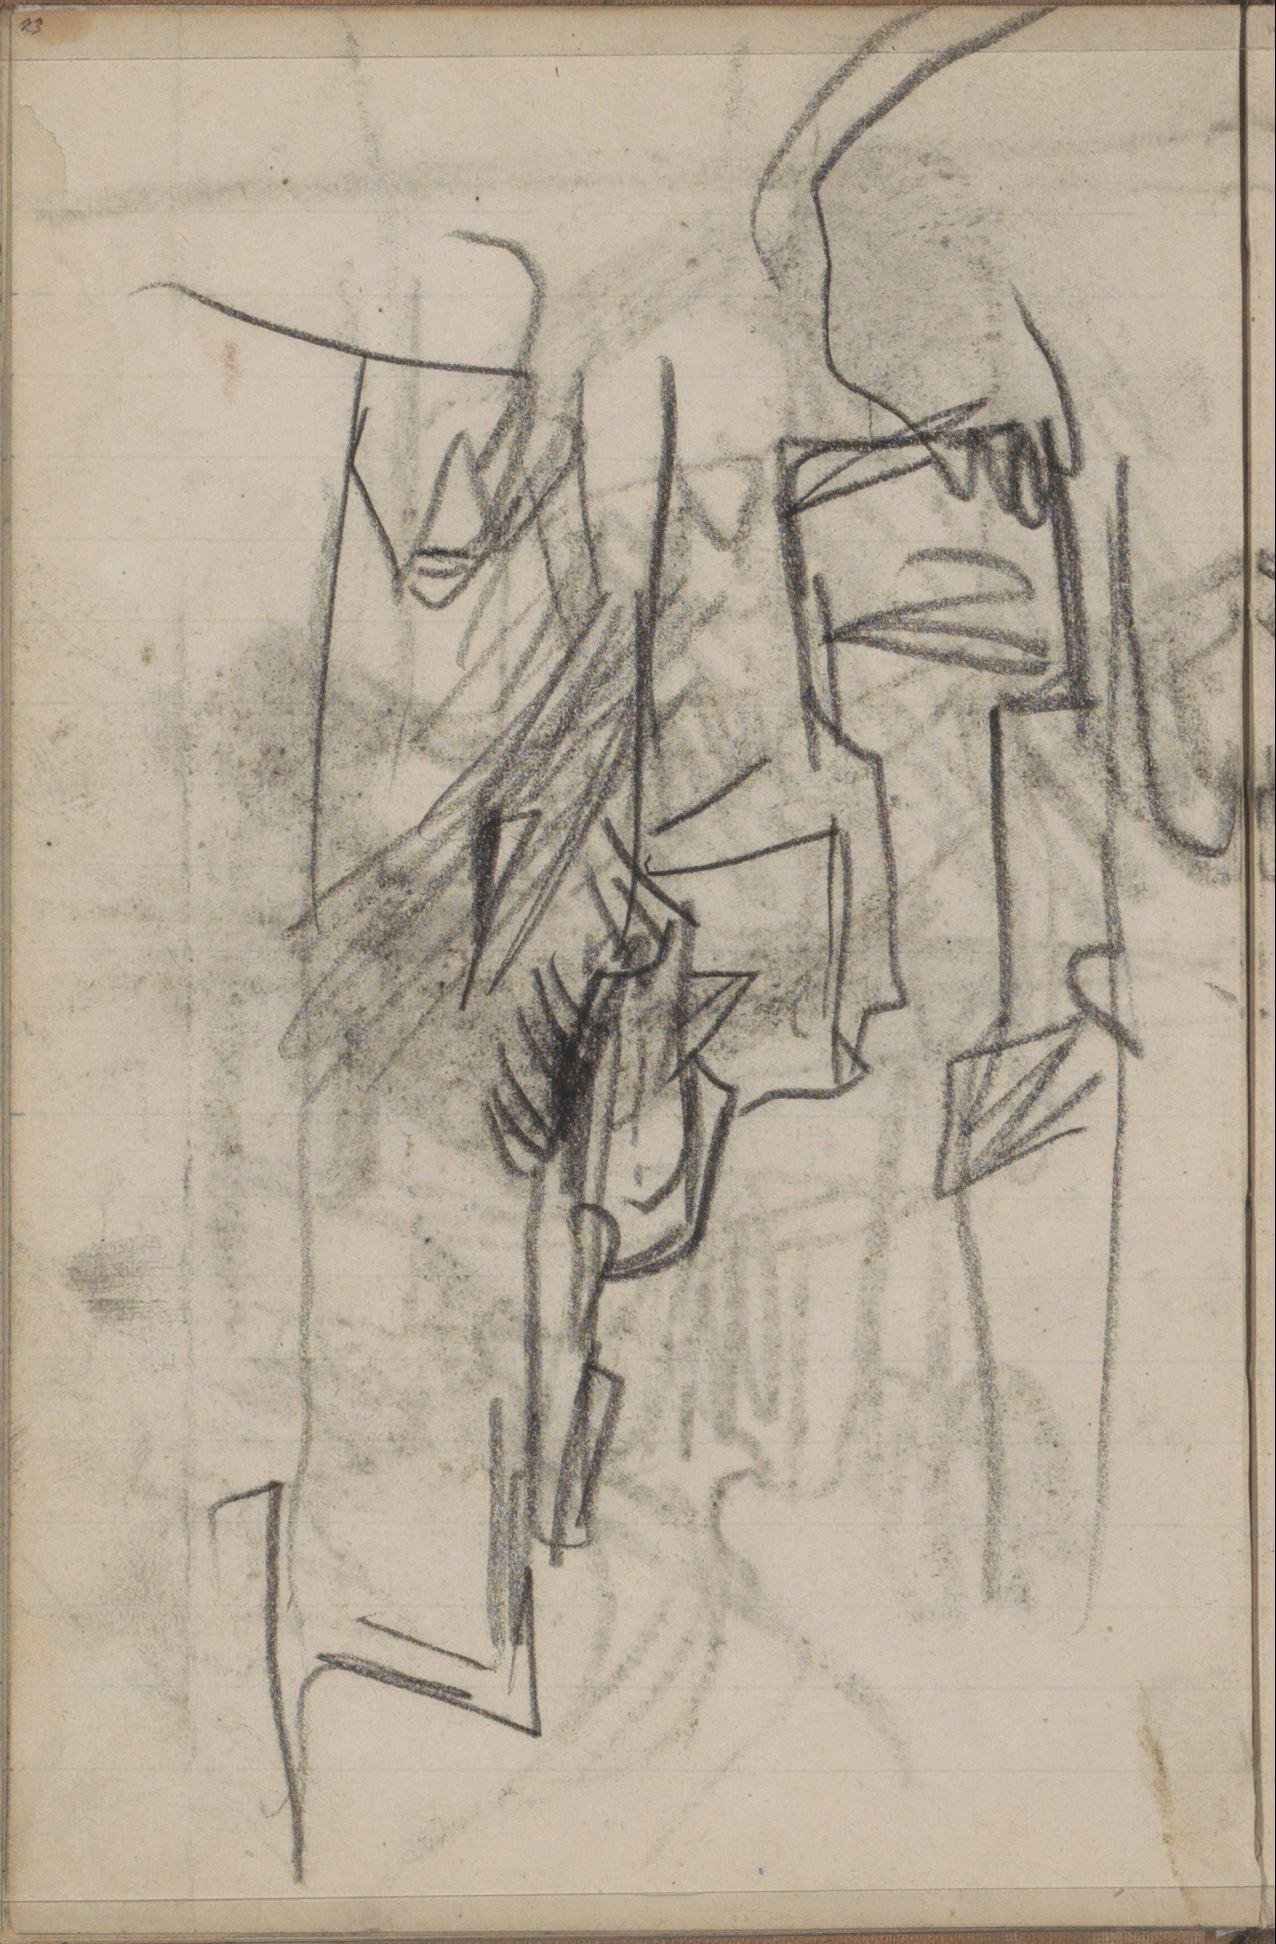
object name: sketchbook leaf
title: Studieblad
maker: marius bauer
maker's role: draughtsman, print maker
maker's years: 1867-1932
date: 1888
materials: chalk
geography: istanbul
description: Pagina 23 uit een schetsboek met 56 bladen.